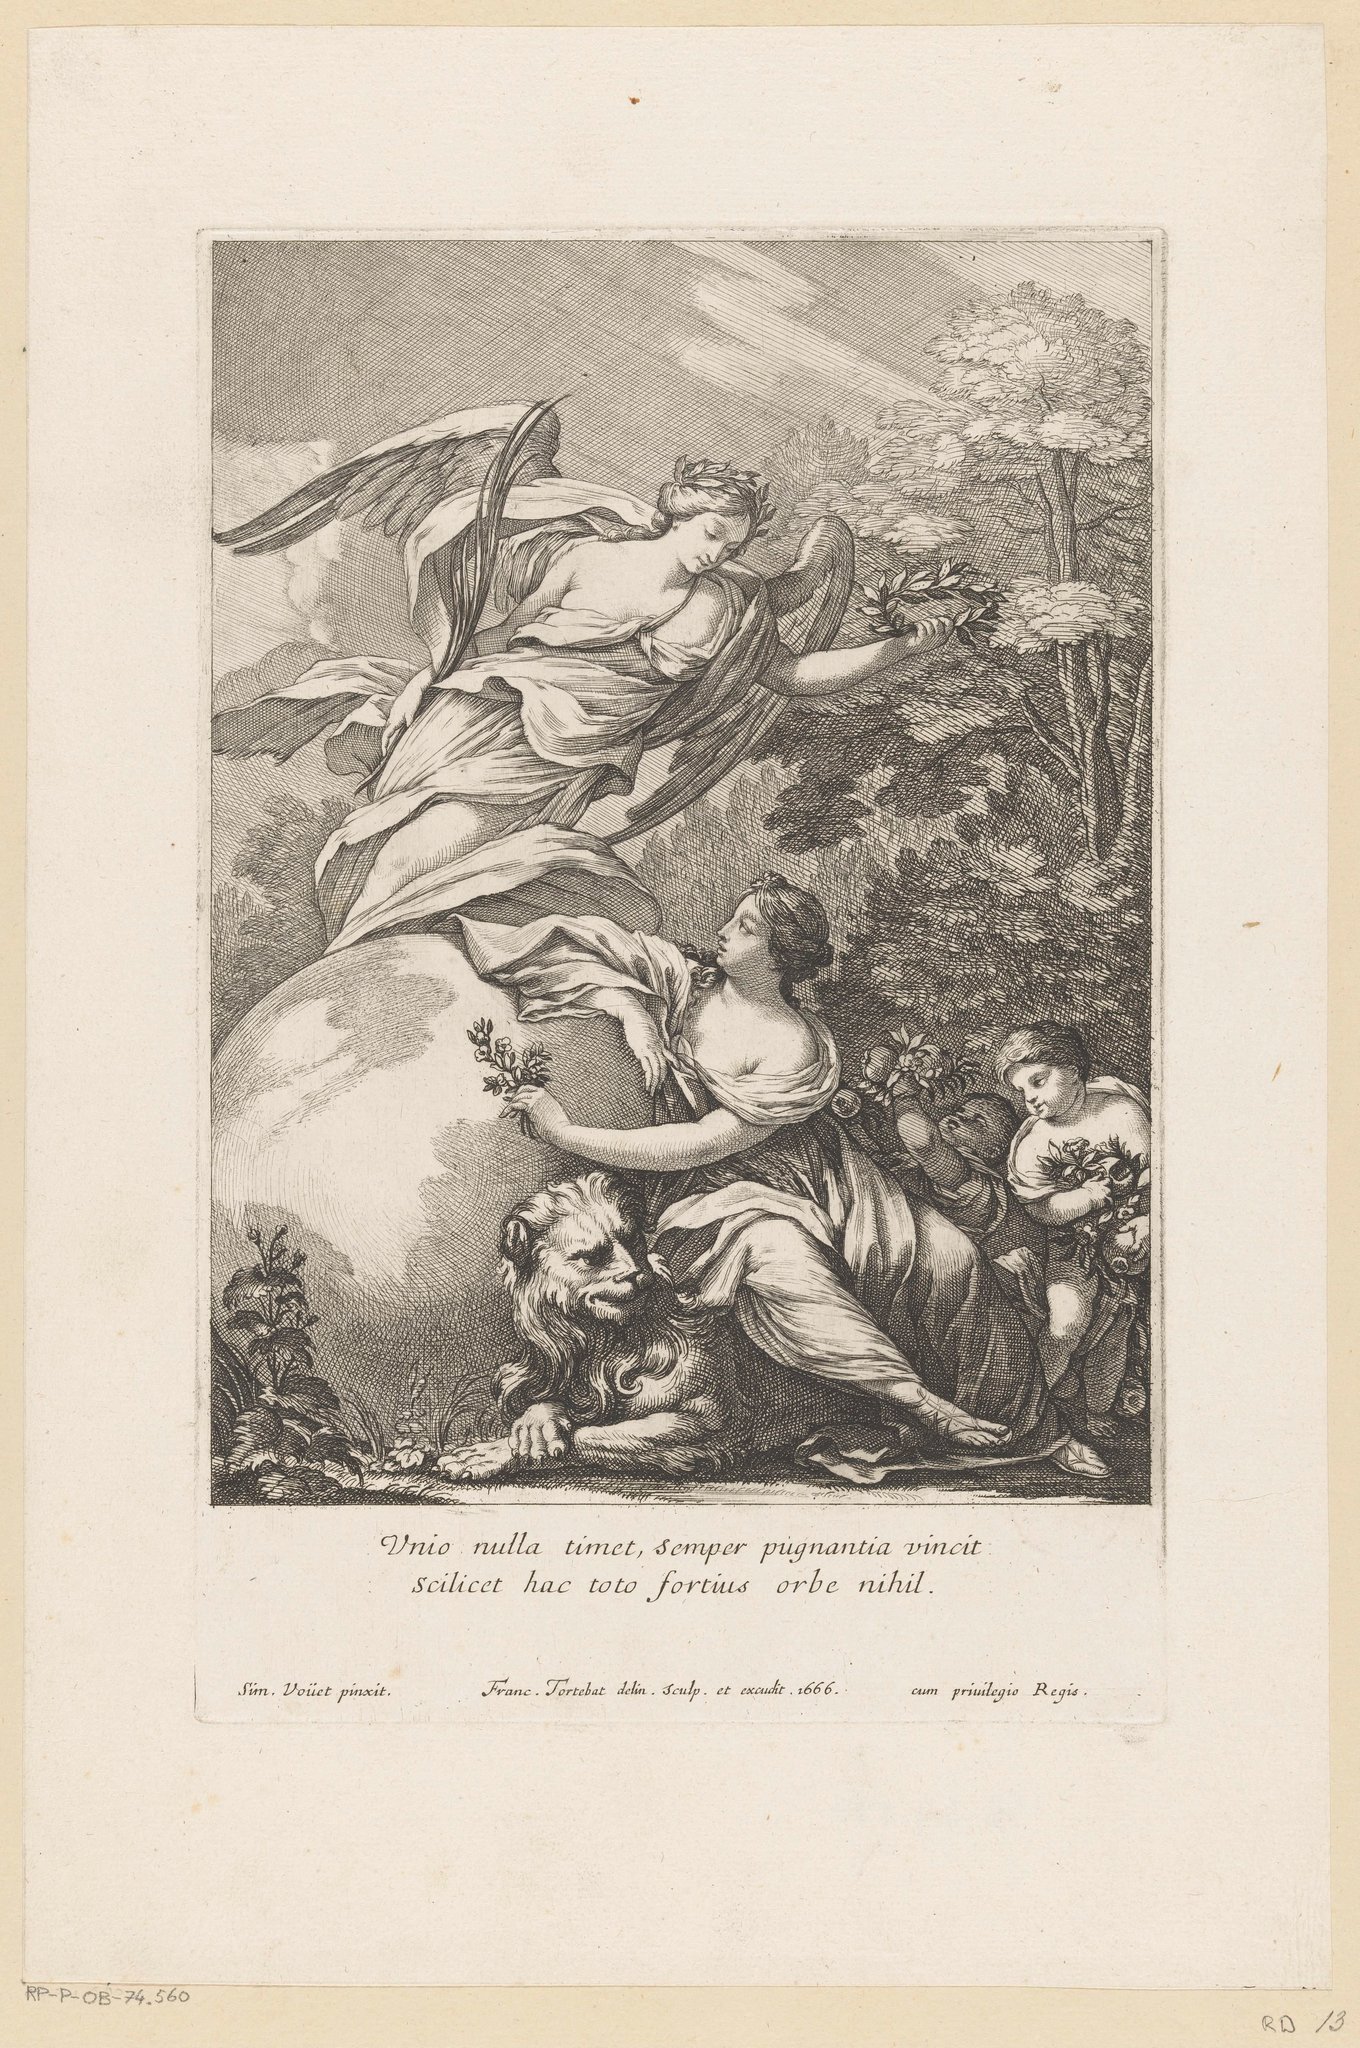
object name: print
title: Allegorie op de Kracht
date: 1666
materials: paper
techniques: engraving, etching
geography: paris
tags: figure representing a virtue vs. a vice, fortitude, 'fortitudo' ~ one of the four cardinal virtues, beasts of prey, predatory animals: lion, angels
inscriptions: collector's mark: Lugt 240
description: Kracht zittend op een leeuw en leunend op een globe waarboven Victoria zweeft met een lauwerkrans in haar hand.